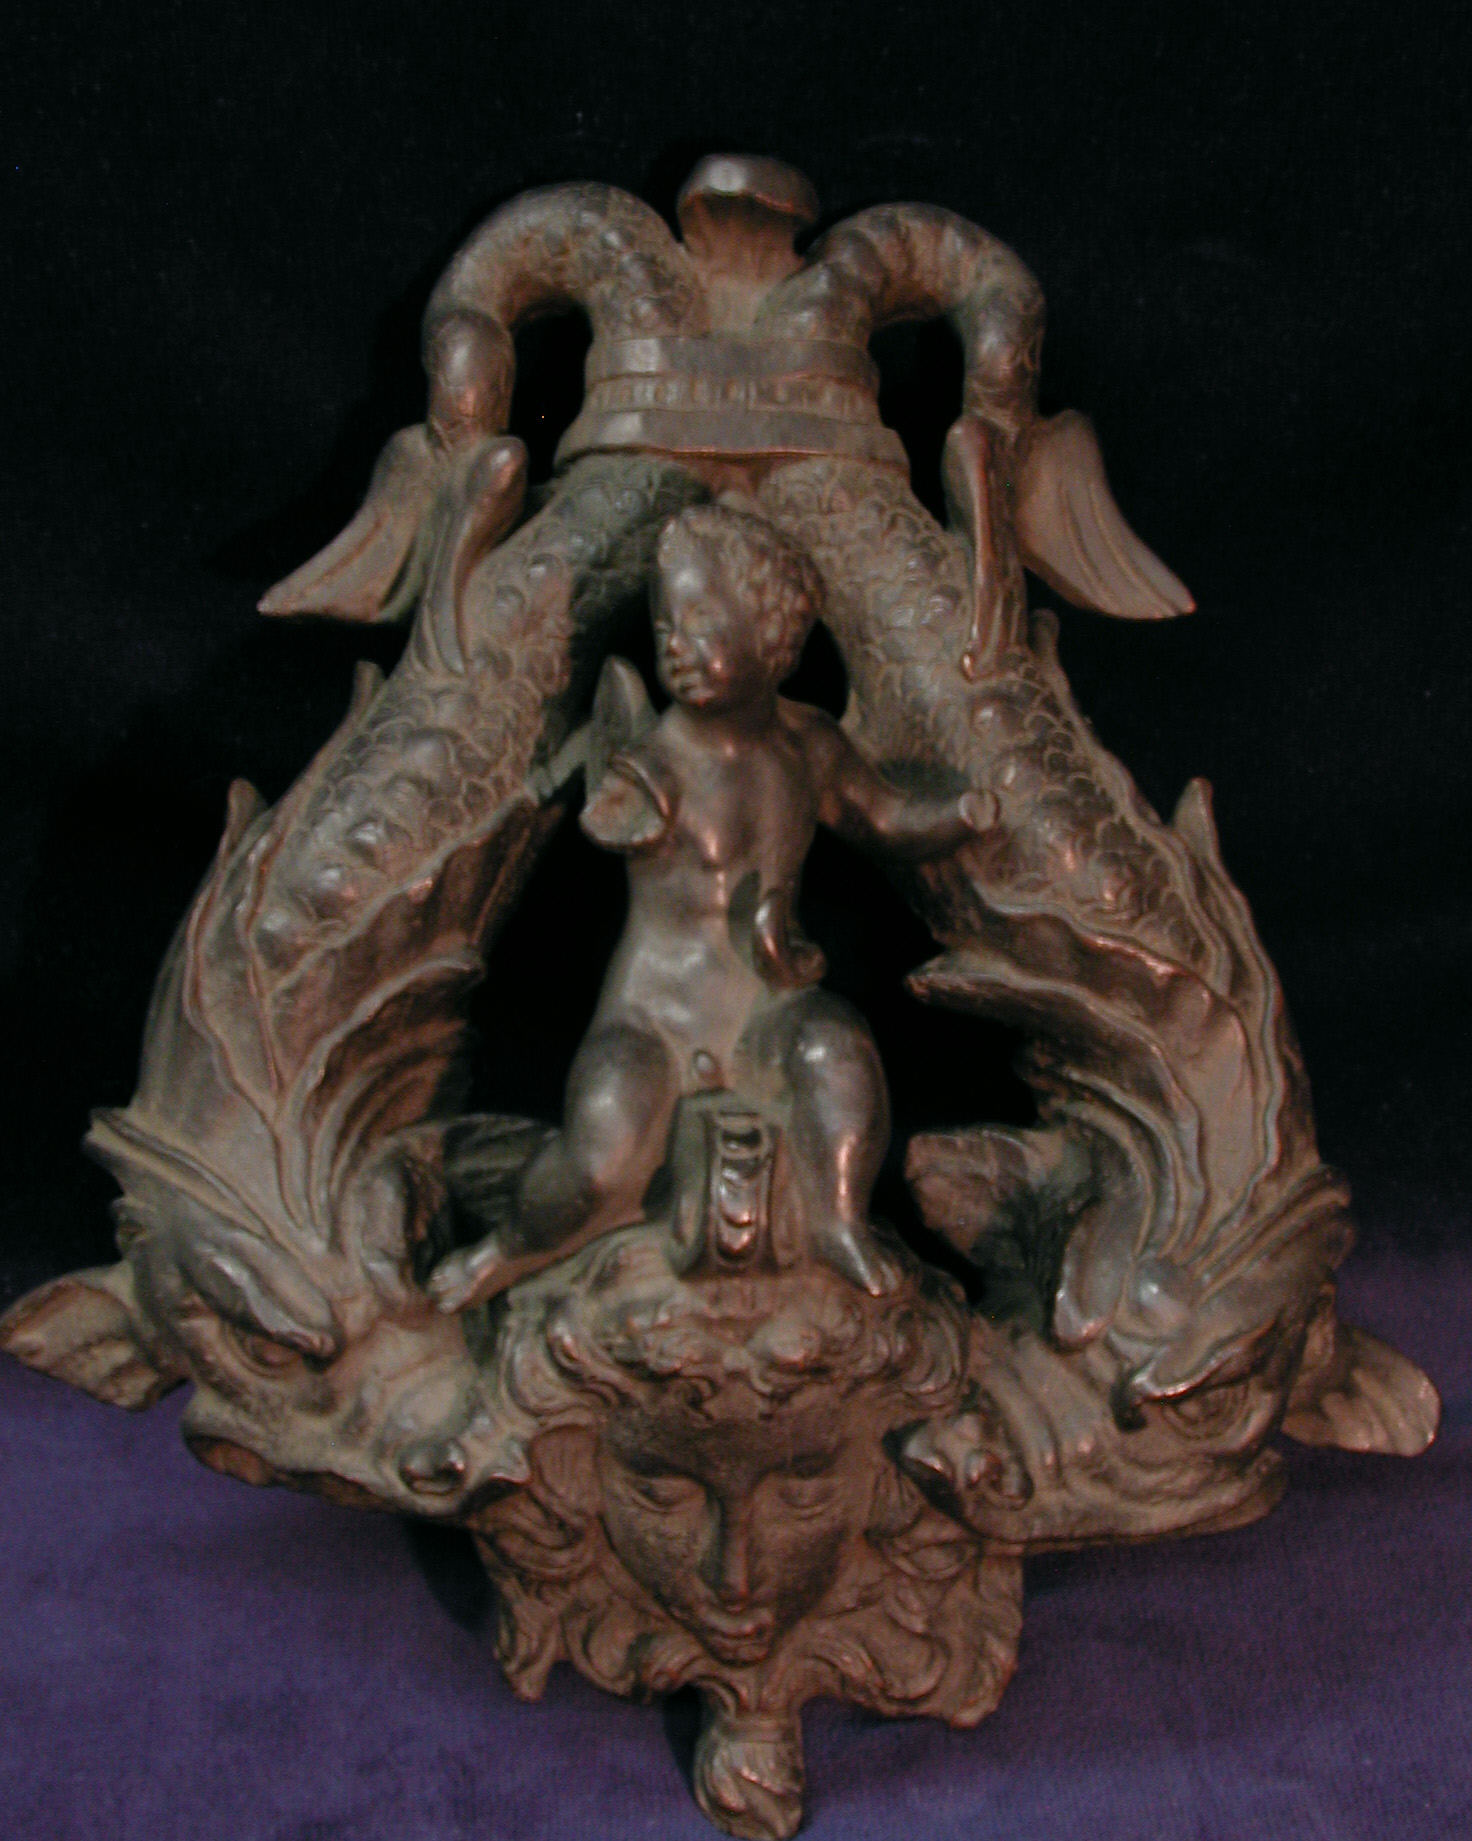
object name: door knocker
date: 1801-1900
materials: bronze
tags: faces,cupid,dolphins